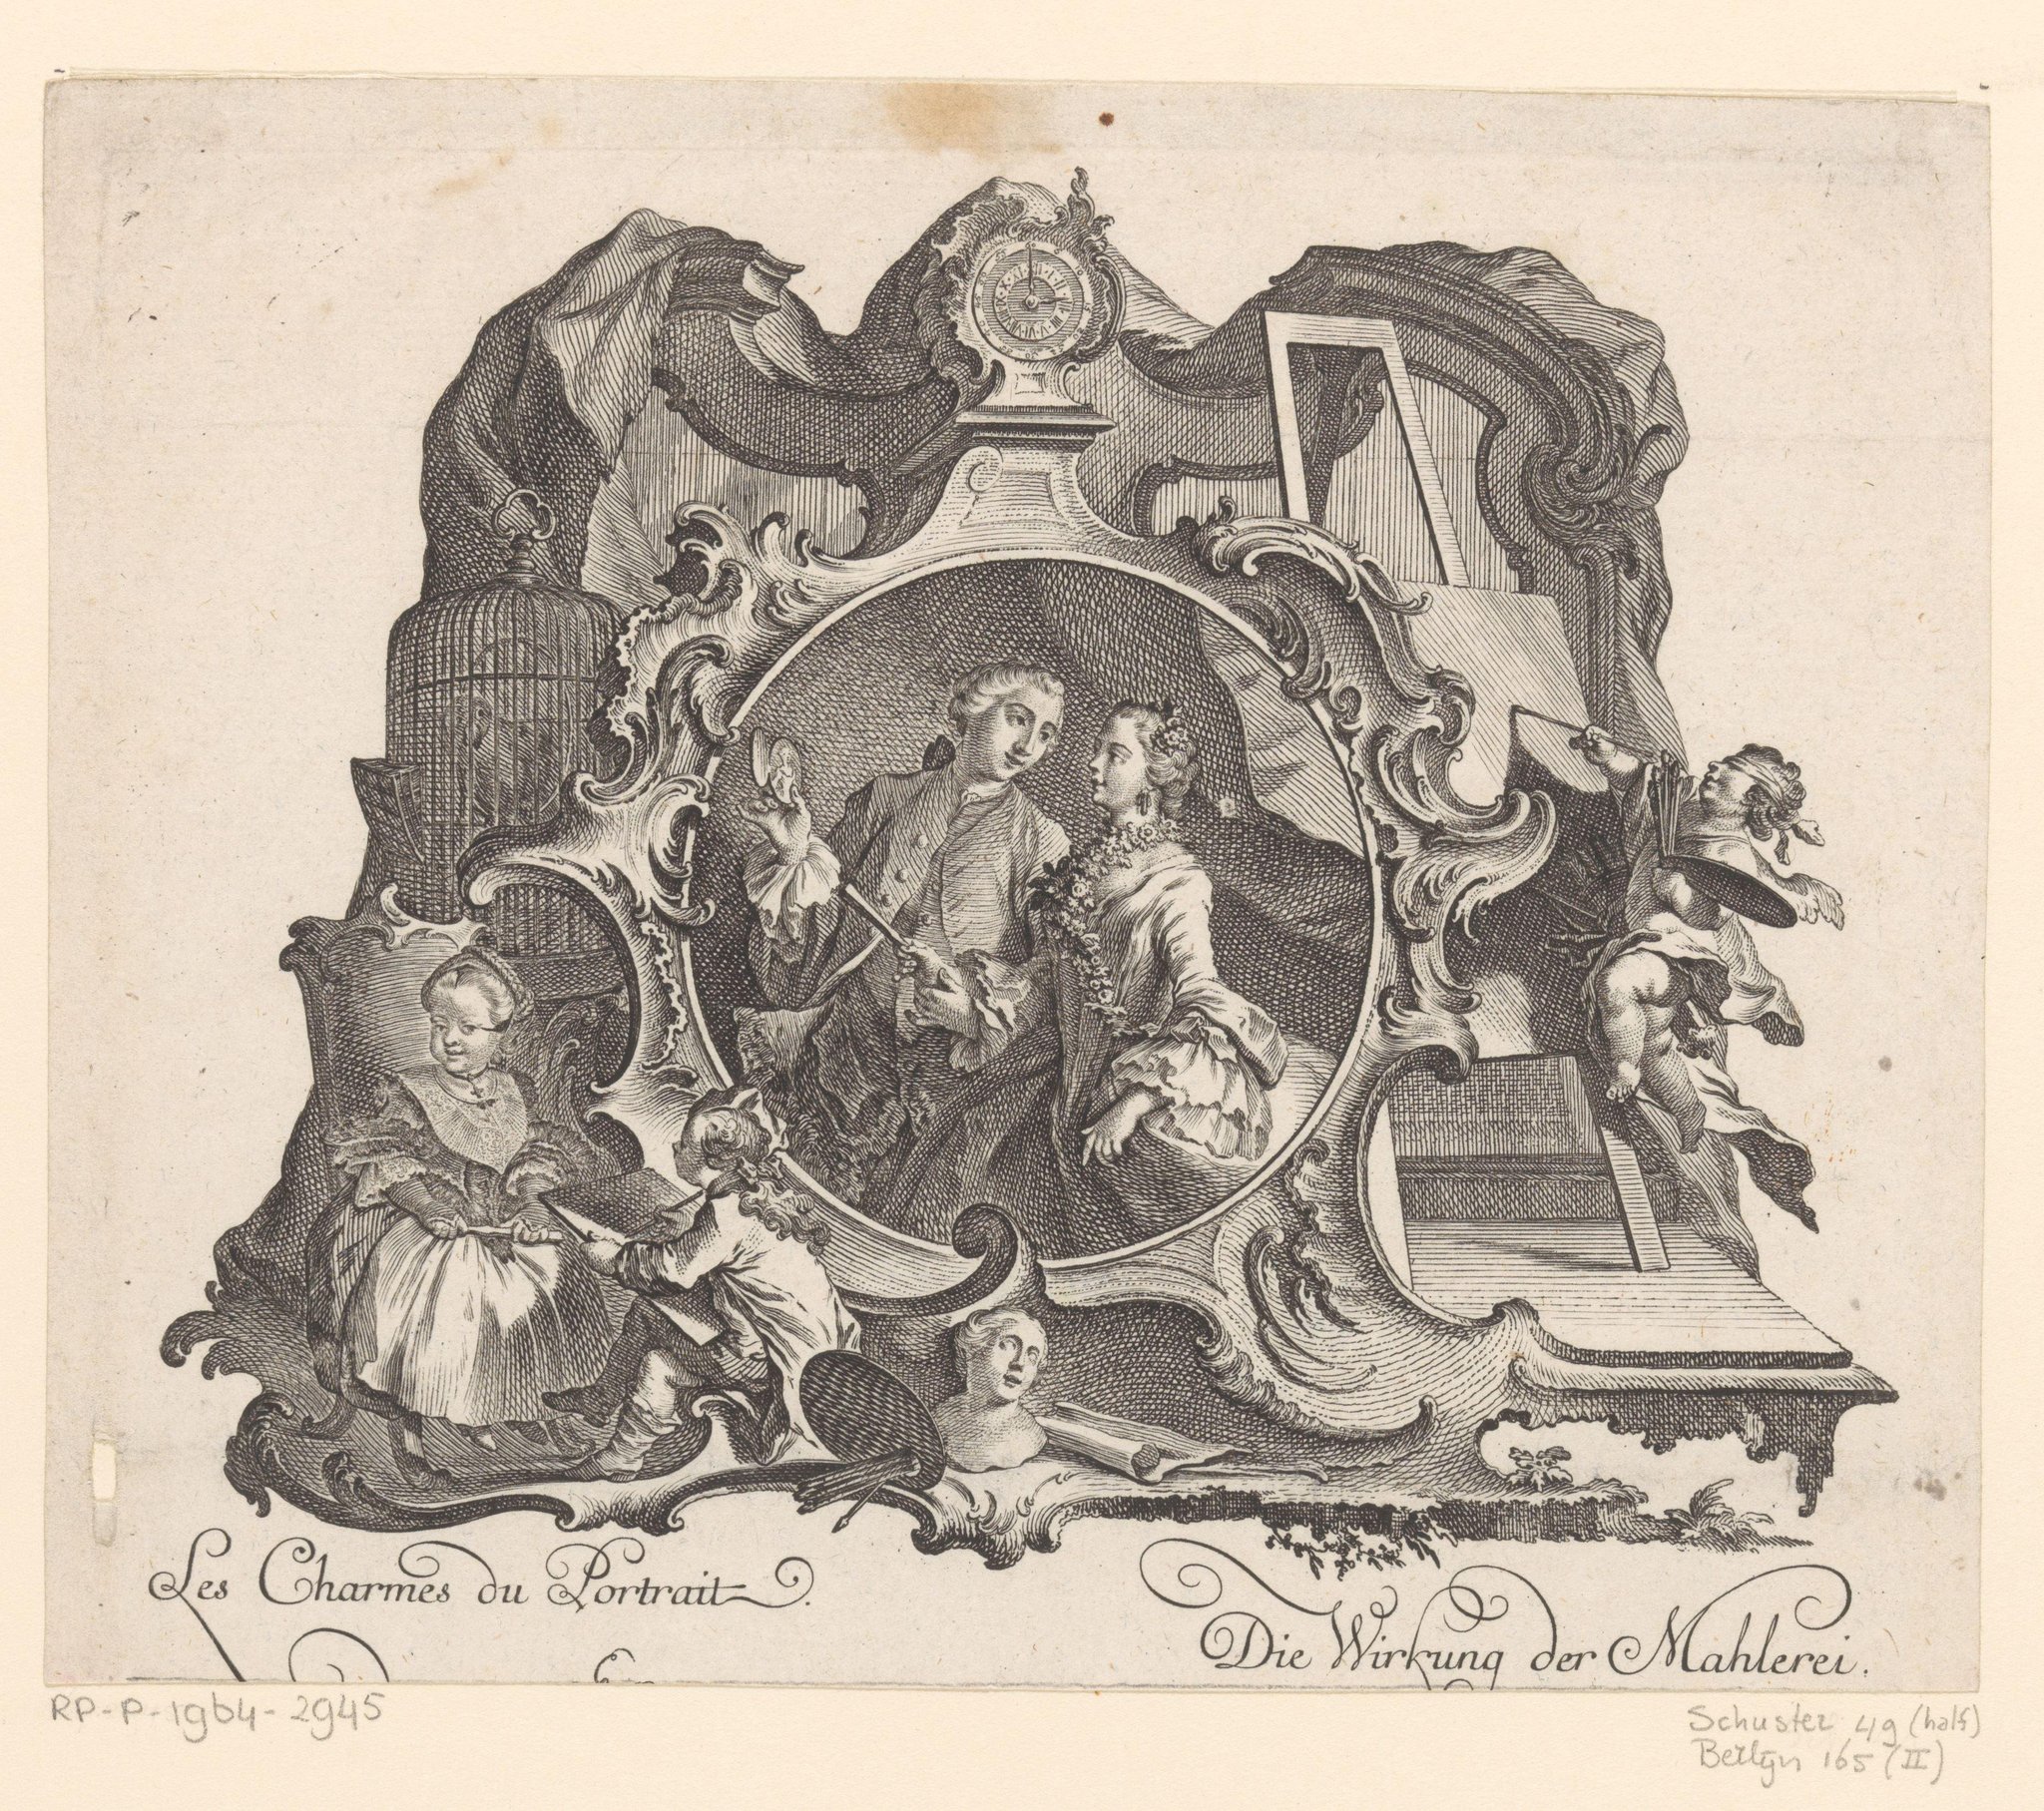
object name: ornament print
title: Charme van het portret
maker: johann esaias nilson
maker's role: draughtsman, print maker, publisher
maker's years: 1721-1788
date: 1731-1788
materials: paper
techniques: engraving, etching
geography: augsburg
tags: portrait, self-portrait of painter, painter at work, in his studio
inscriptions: collector's mark: Lugt 2760, collector's mark: Lugt 2228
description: De bovenste helft van een blad met twee scènes. Een man toont een vrouw haar miniatuurportret. De voorstelling bevindt zich in een ronde lijst omgeven door rocaille ornamenten, een schilder met zijn model en een schilderende putto.